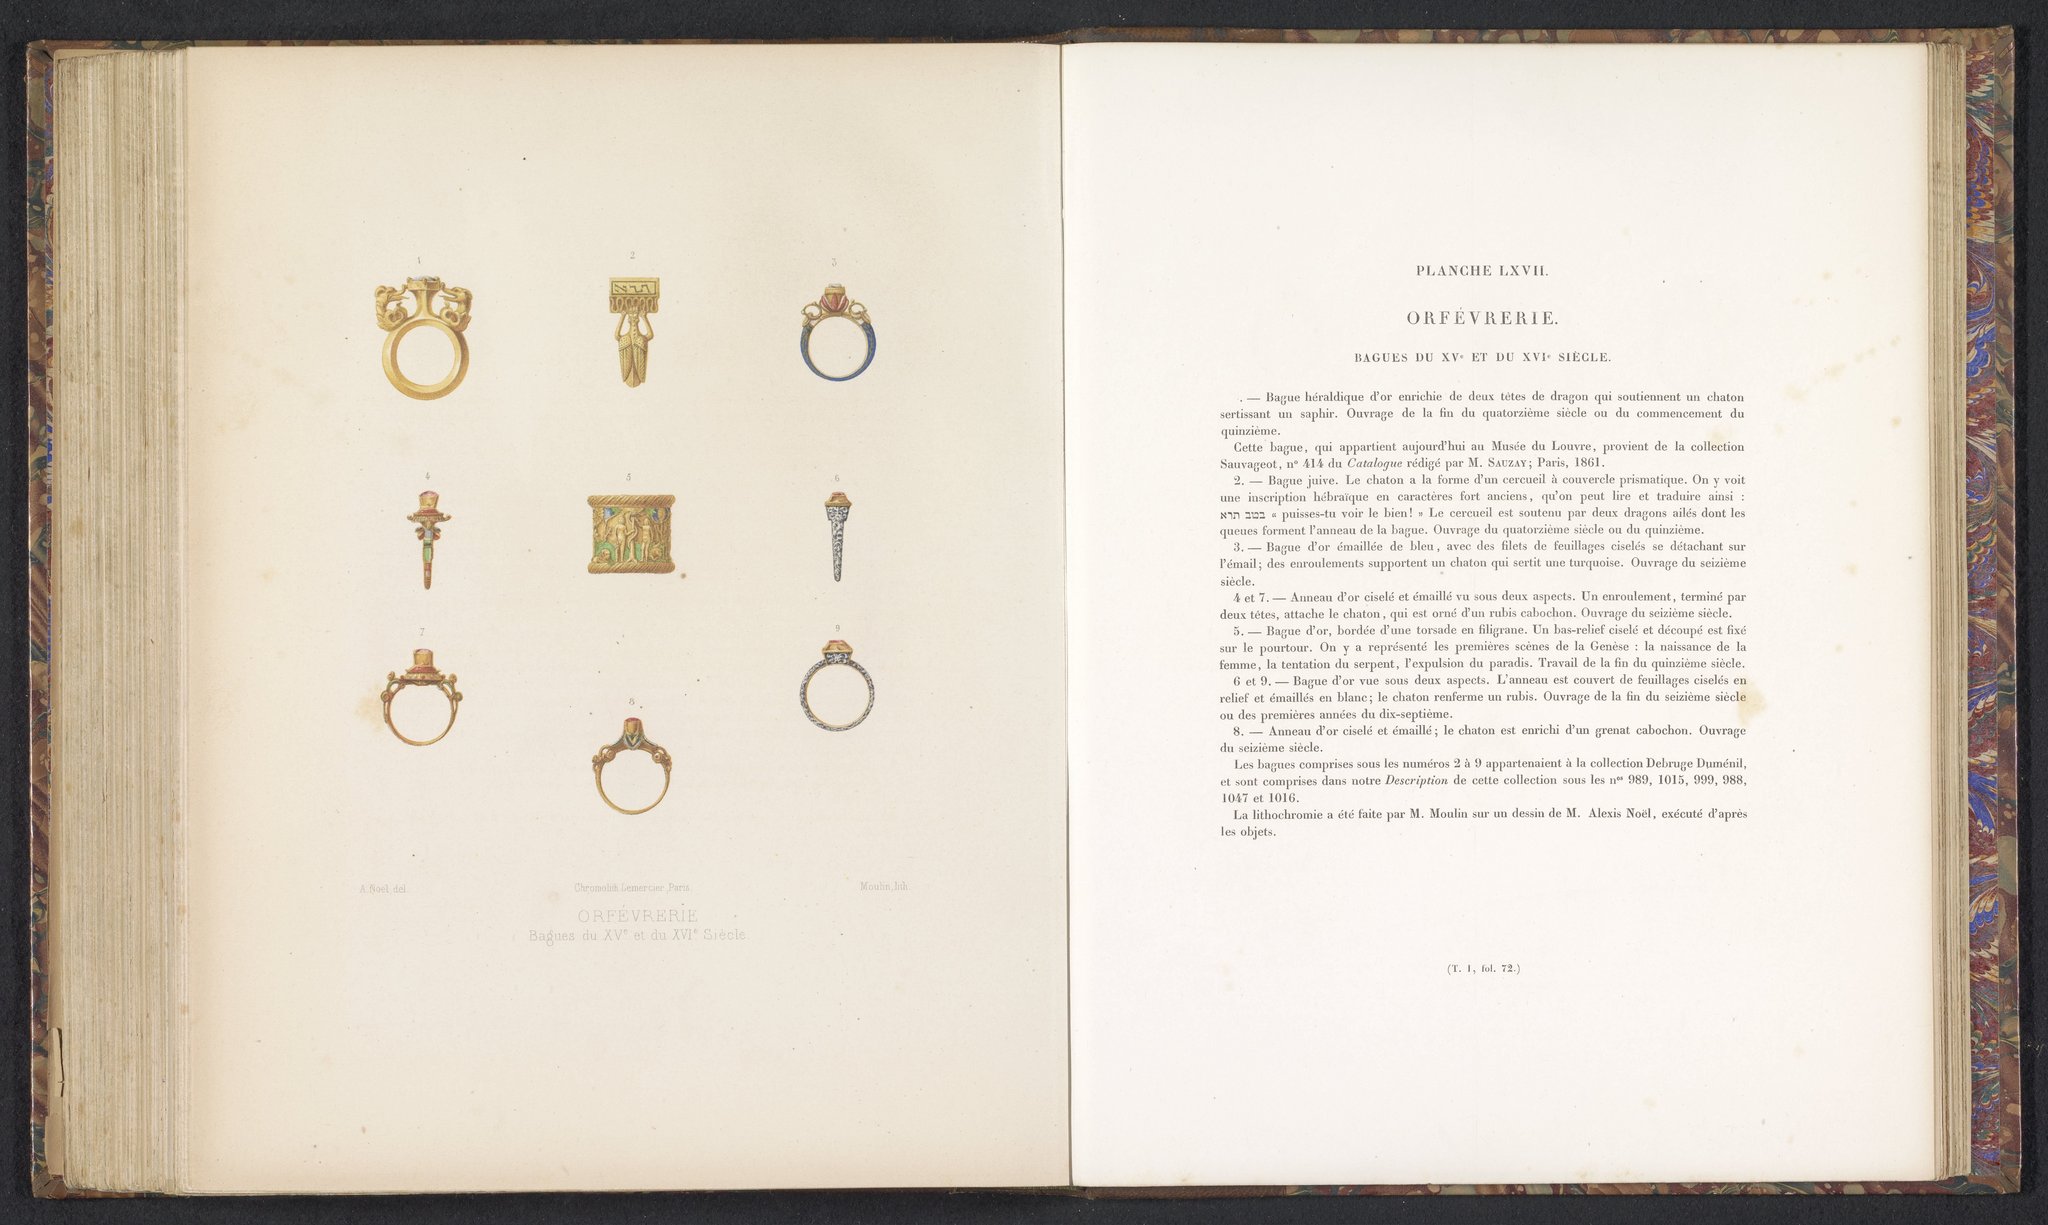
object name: photomechanical print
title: Bagues du XVe et du XVIe siècle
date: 1859-1864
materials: paper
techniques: photolithography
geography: paris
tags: ring